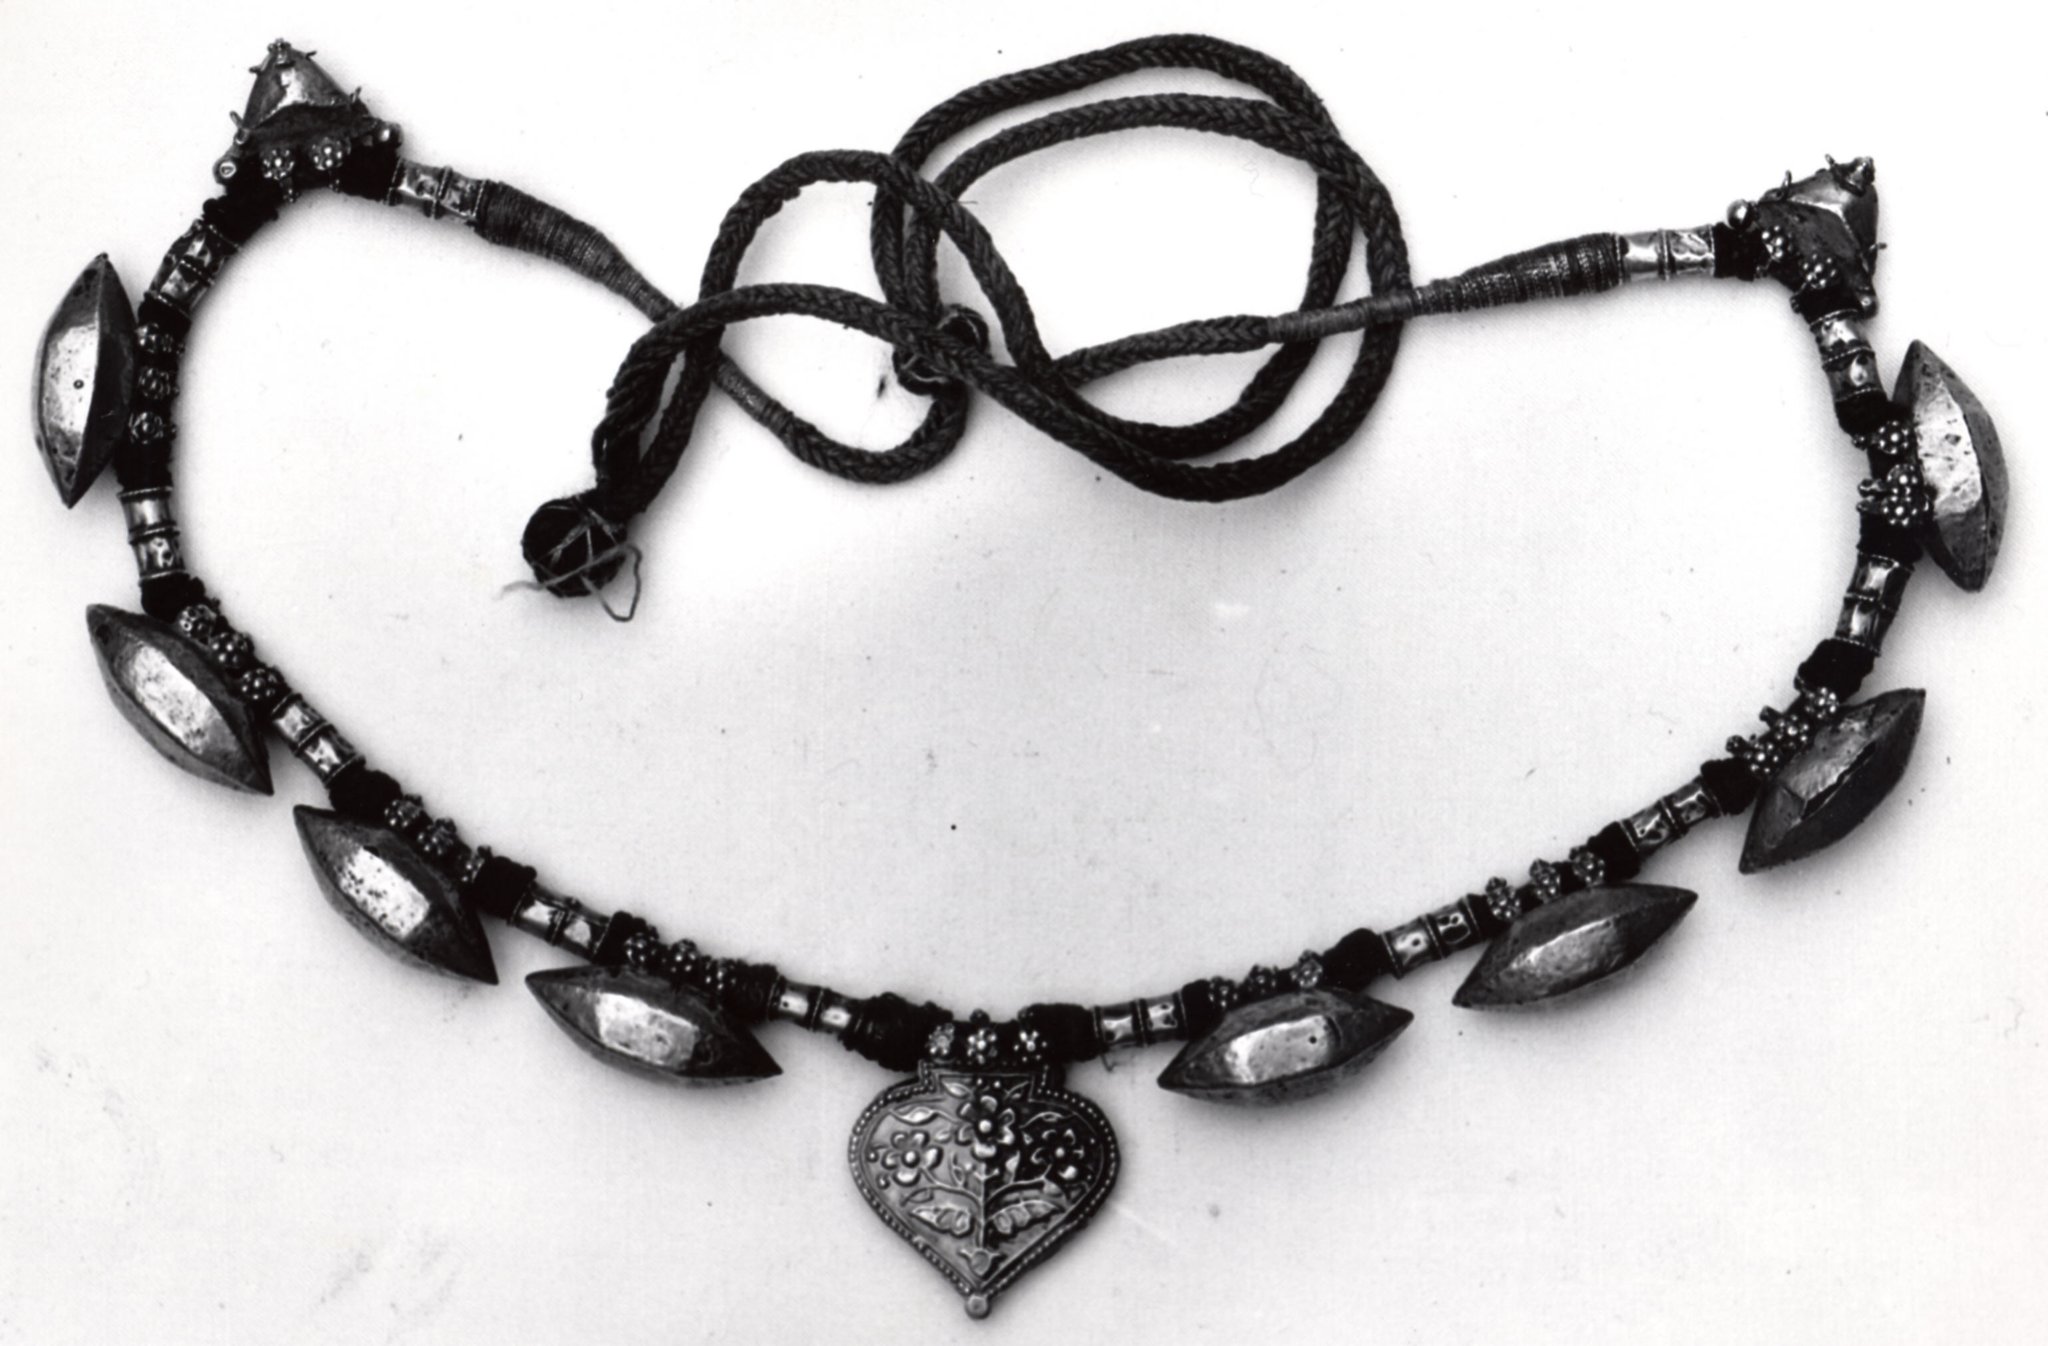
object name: necklace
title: Necklace (Galaband)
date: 1701-1900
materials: gold, silver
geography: india